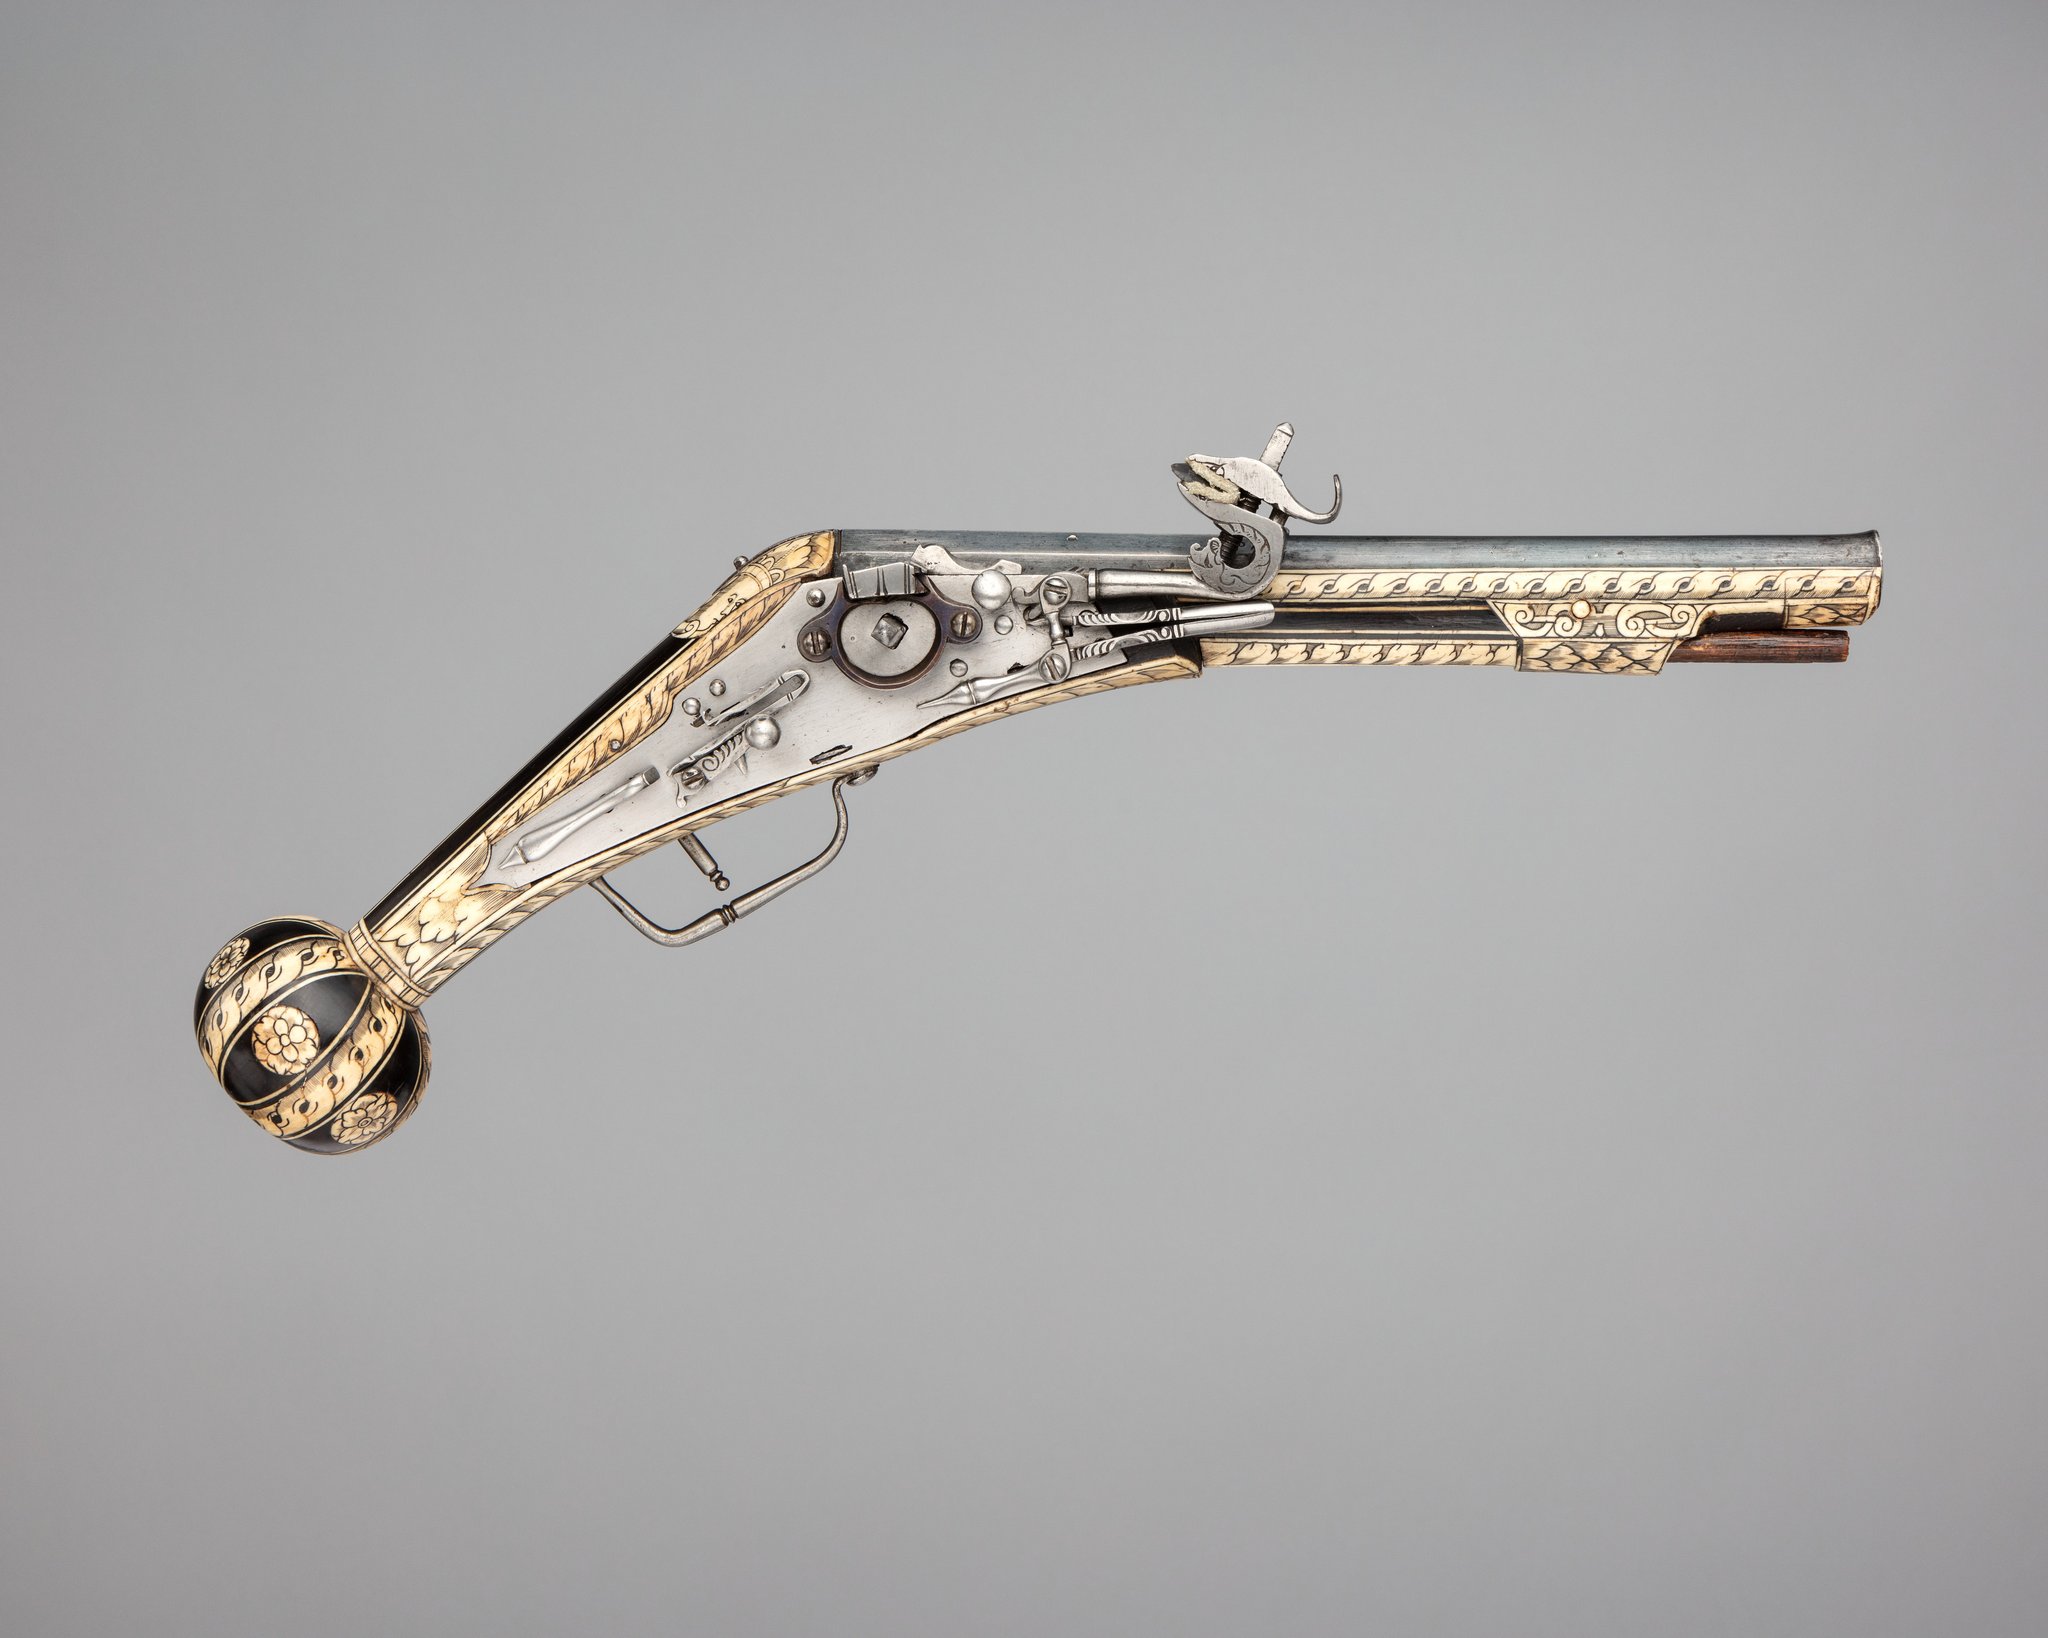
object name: wheellock pistol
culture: german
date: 1570-1580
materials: steel, wood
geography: country